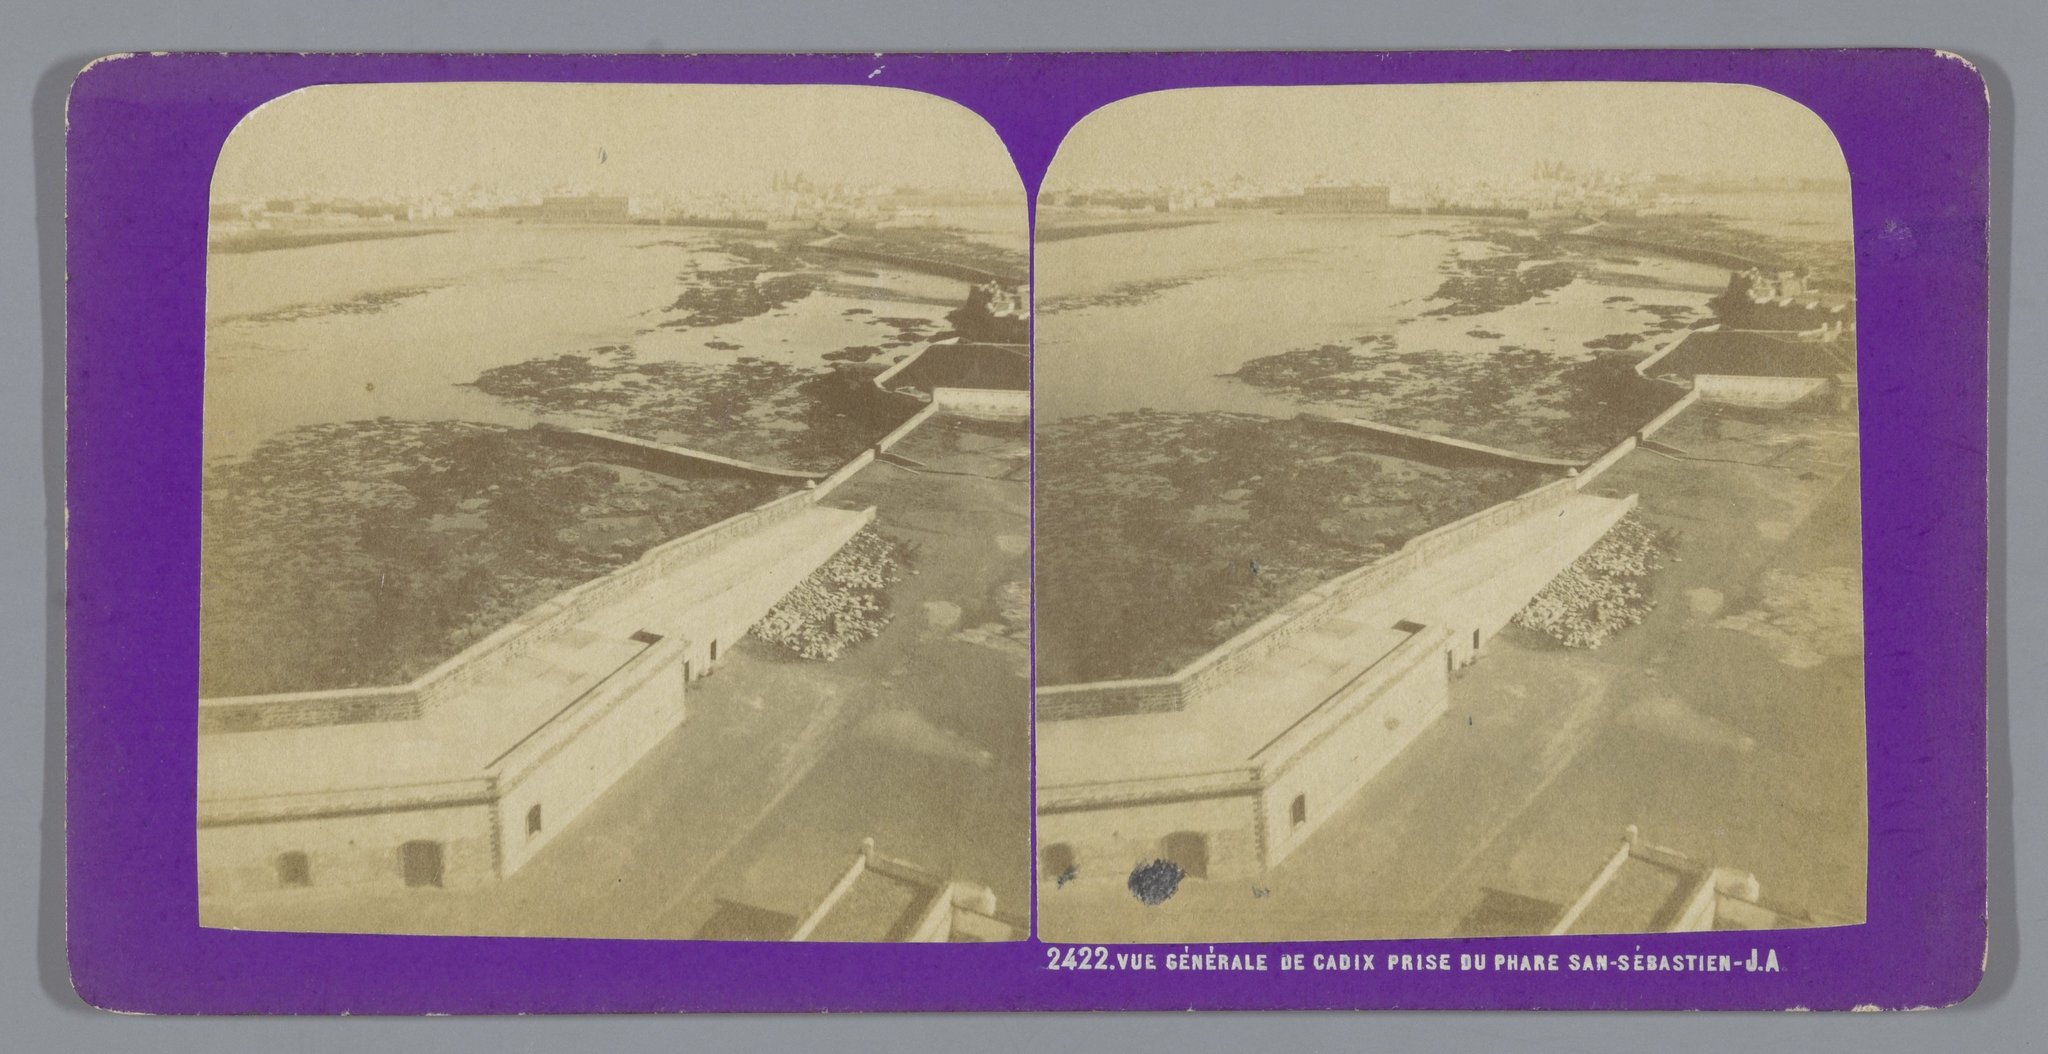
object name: stereograph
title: Gezicht op Cádiz, gezien vanaf de vuurtoren van San Sebastián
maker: jean andrieu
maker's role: fotograaf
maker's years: 1816-1872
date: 1862-1876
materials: cardboard, photographic support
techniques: albumen print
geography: donostia-san sebastián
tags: landscapes with waters, waterscapes, seascapes (in the temperate zone), prospect of city, town panorama, silhouette of city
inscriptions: number: ‘2422.’